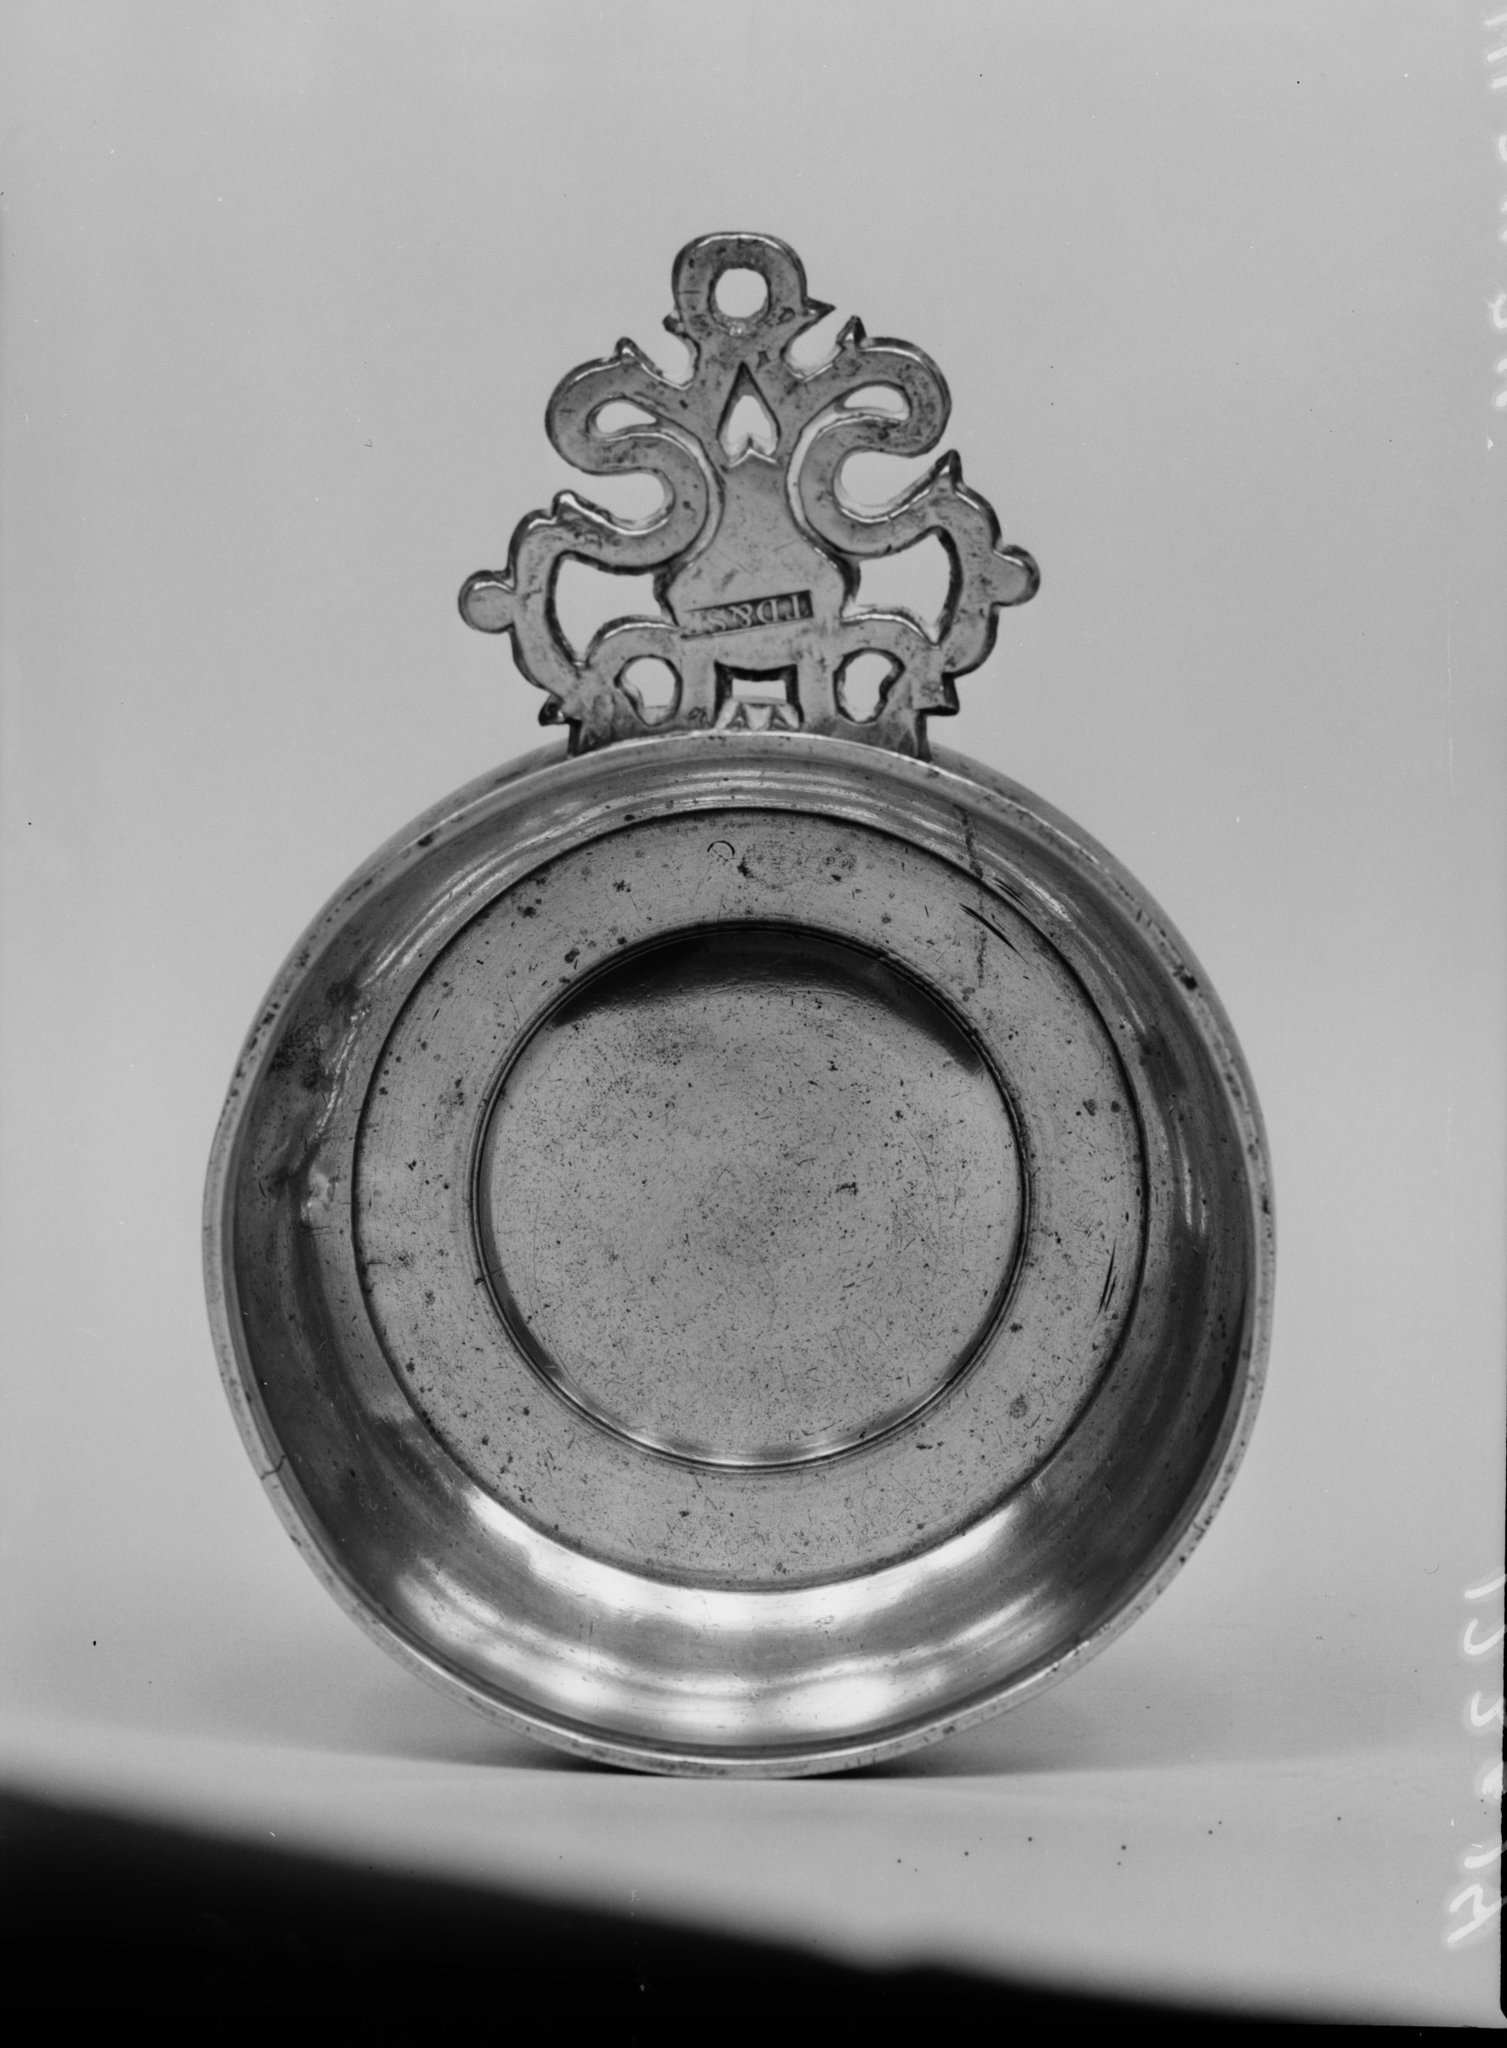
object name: porringer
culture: american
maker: thomas danforth boardman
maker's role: maker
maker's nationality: american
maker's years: 1784-1873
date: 1810-1830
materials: pewter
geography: united states